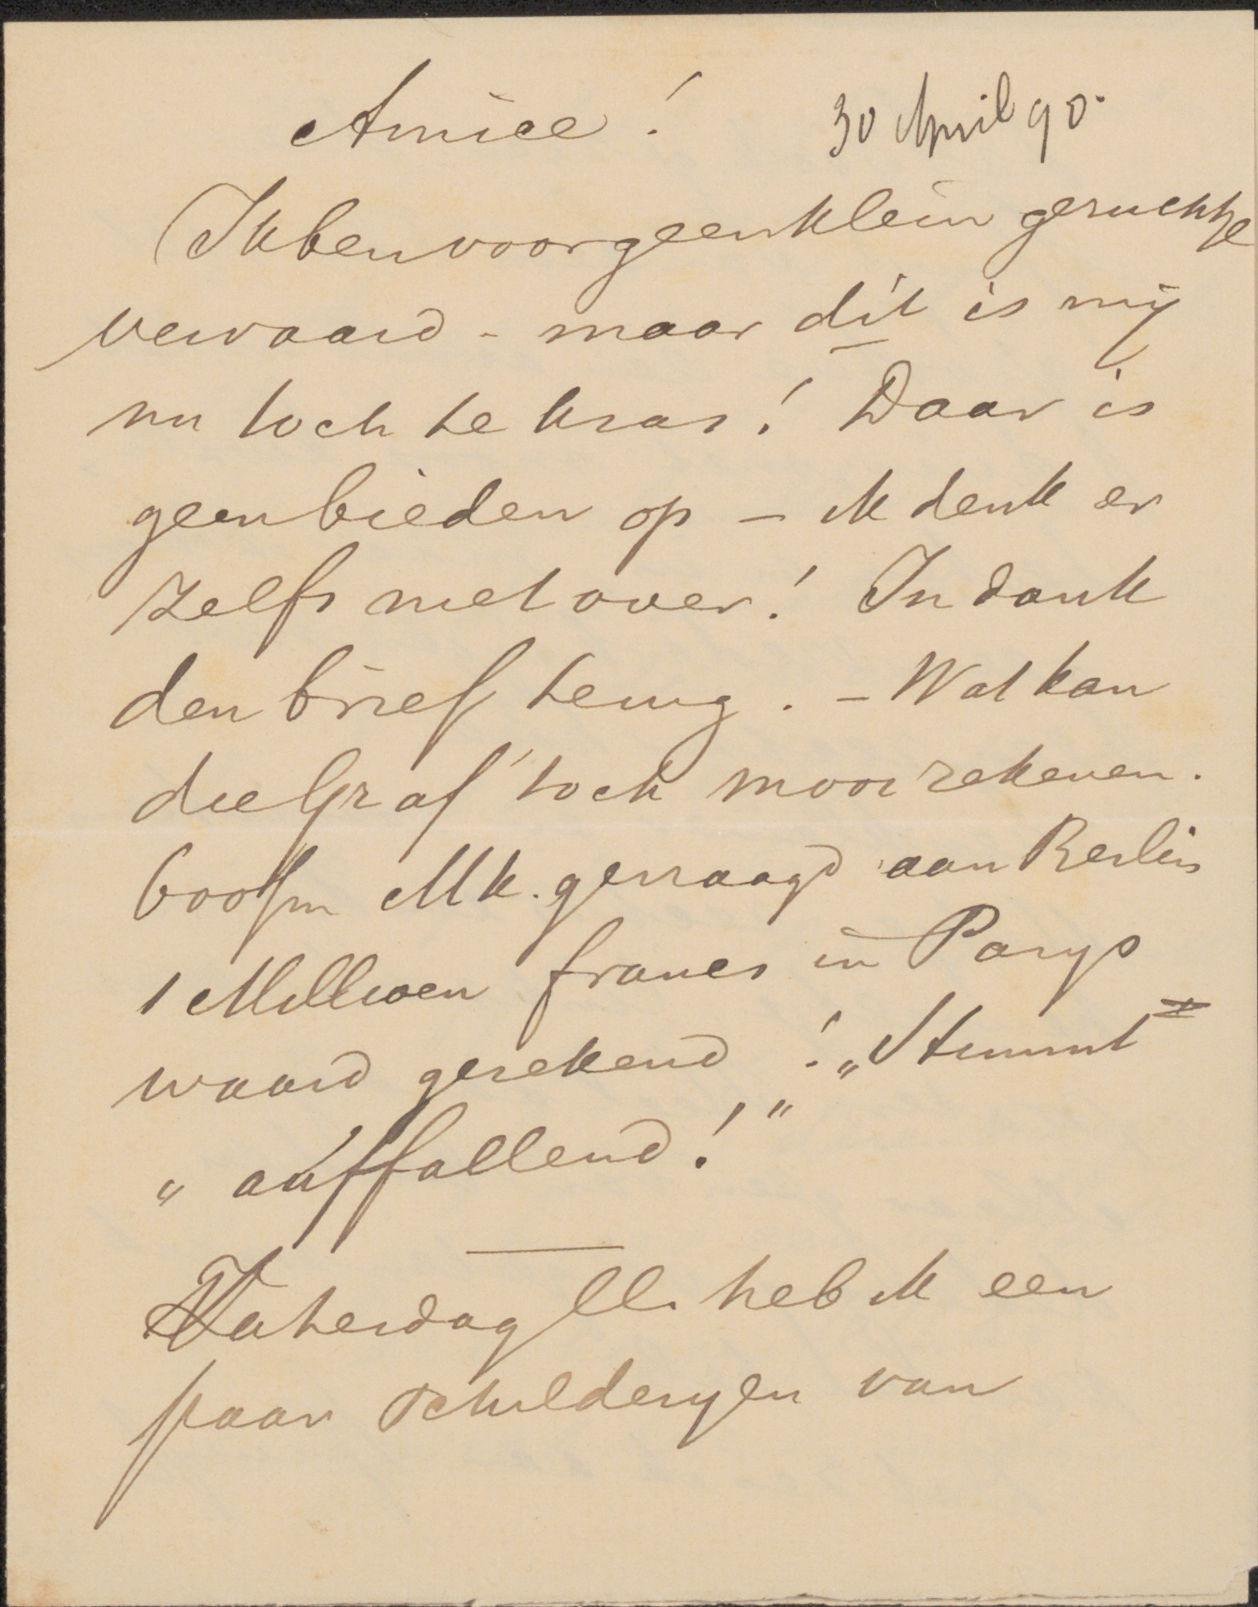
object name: letter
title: Brief aan Jan Veth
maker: martinus cornelis lebret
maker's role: verzamelaar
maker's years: 1833-1894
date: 1890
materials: ink, paper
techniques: pen, writing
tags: theodor graf, the hague, haarlem, painter, print maker, draughtsman, théophile de bock, amsterdam, designer, jan veth, painting (including book-illumination, miniature-painting), money, paris, berlin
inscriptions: collector's mark: ‘RPK’